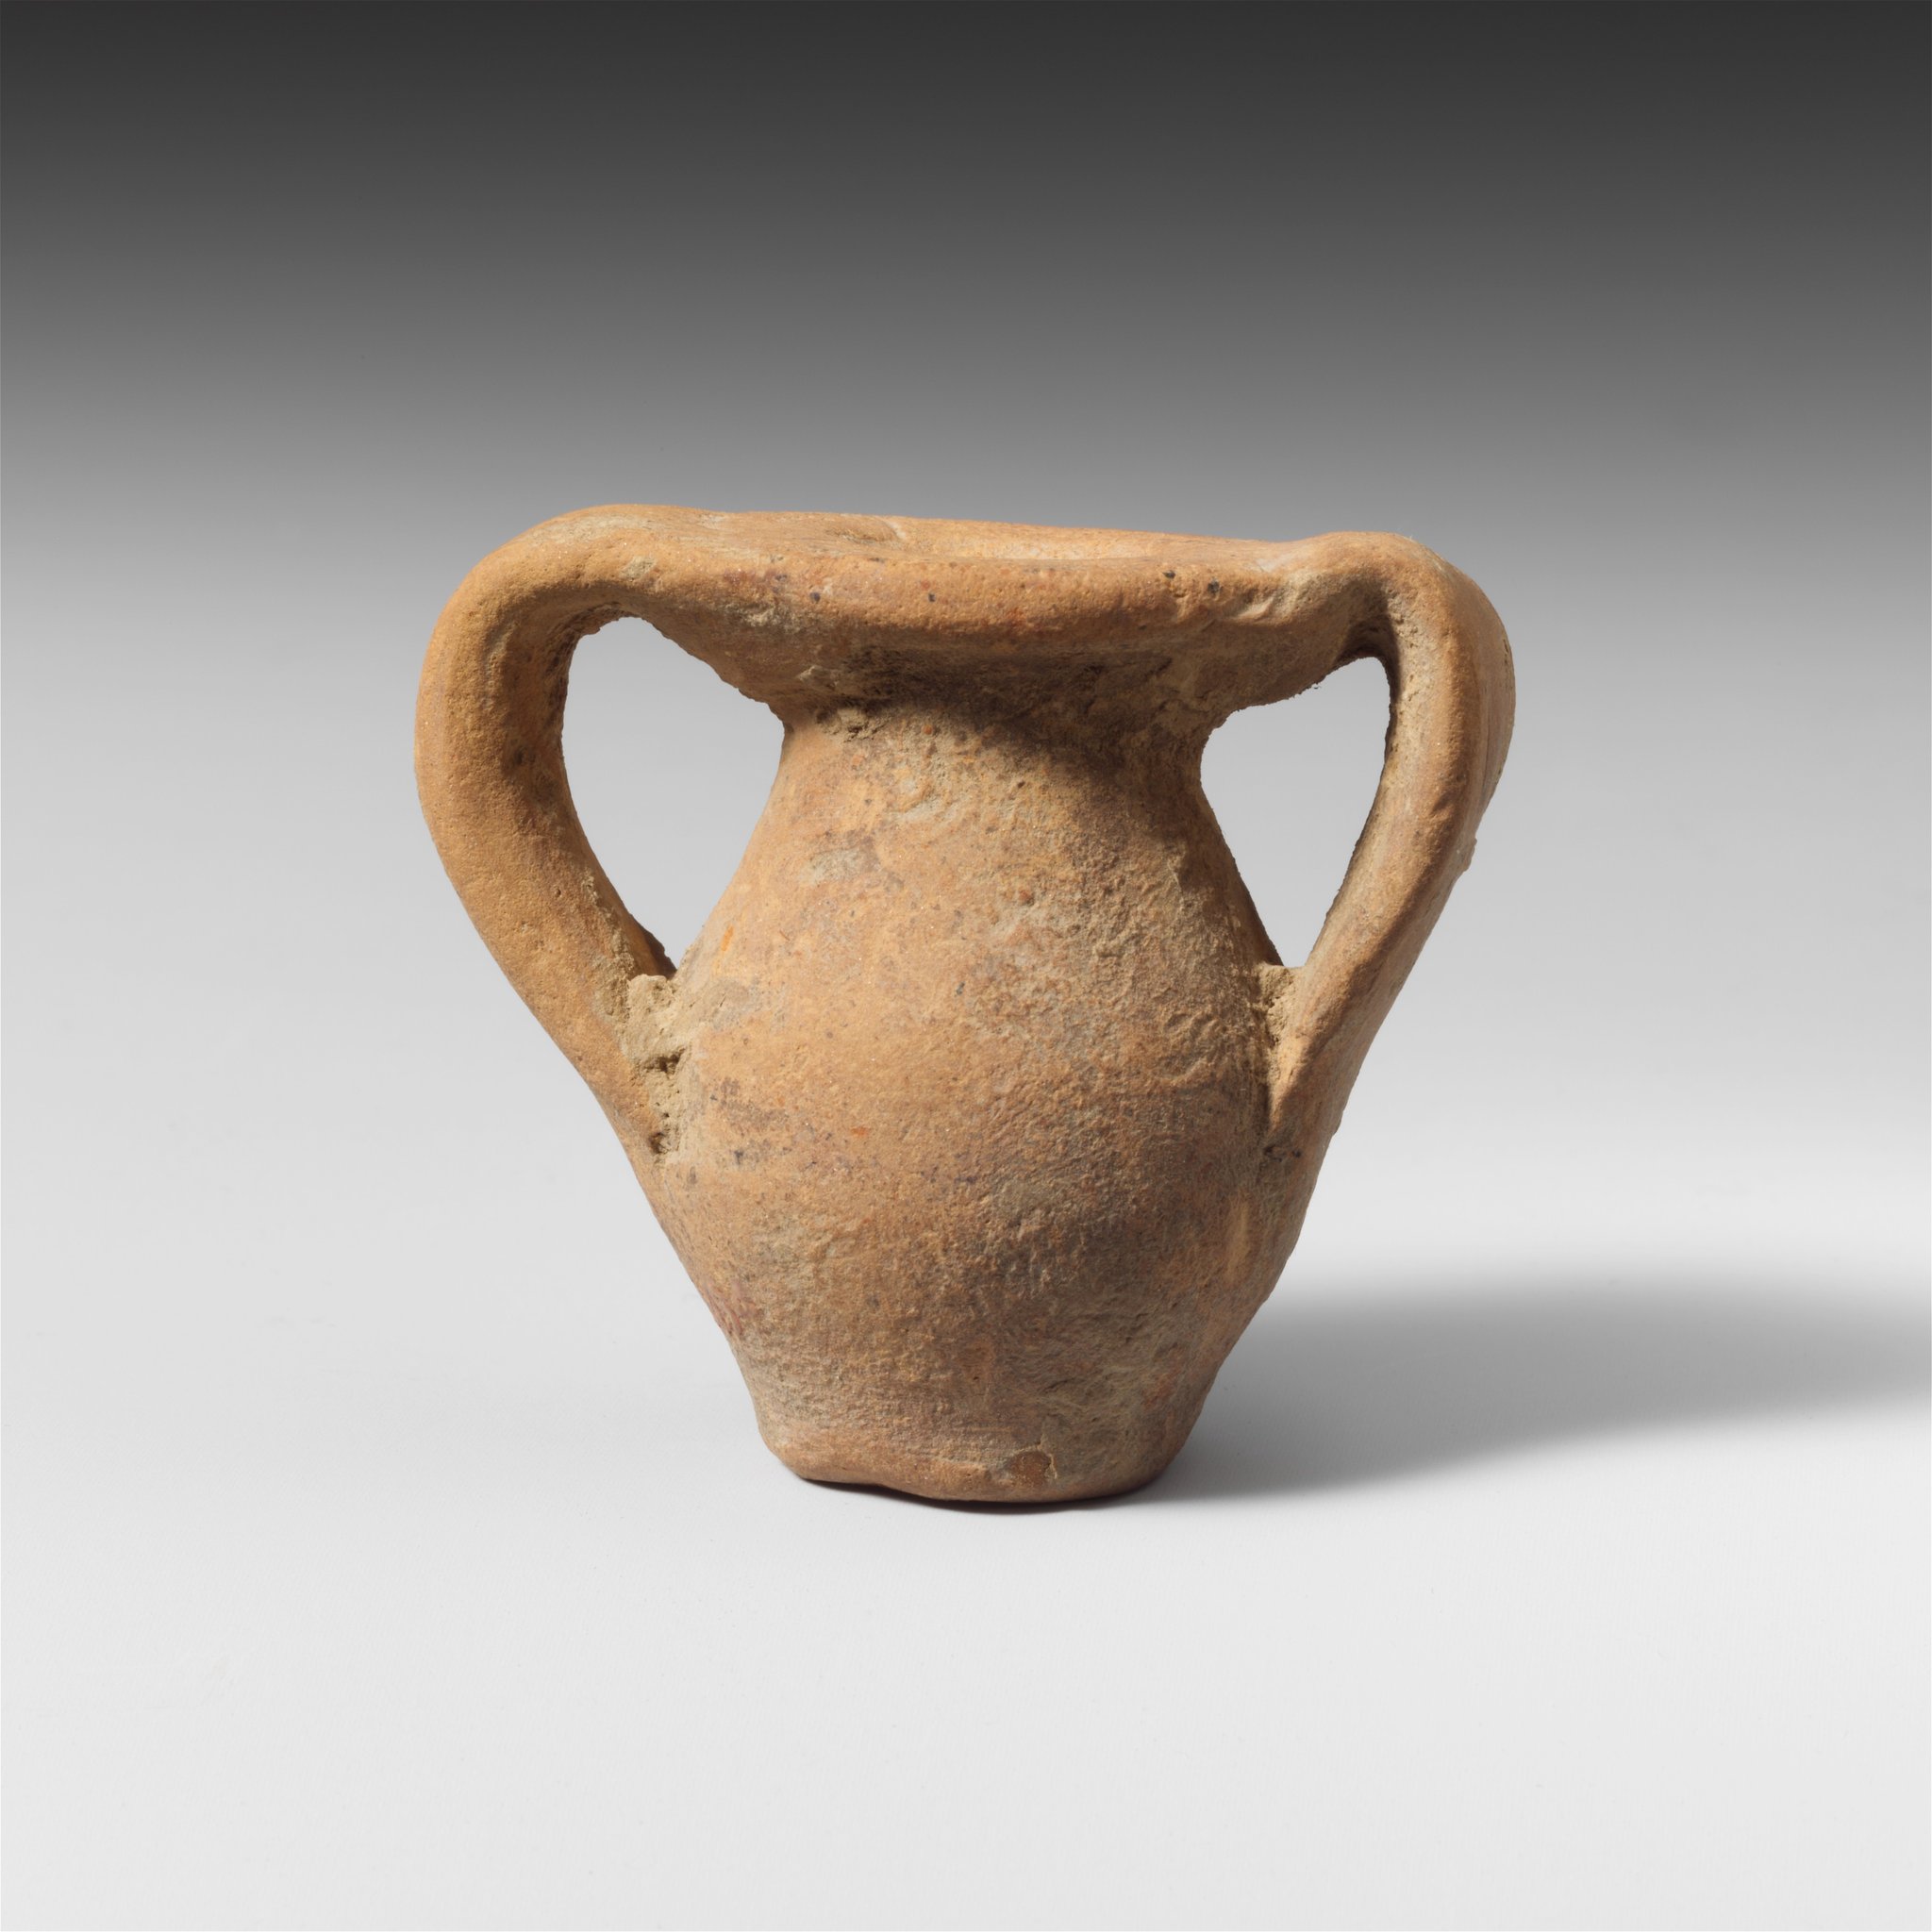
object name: jar, miniature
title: Terracotta miniature jar with two handles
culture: greek, laconian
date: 700-501 BCE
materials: terracotta